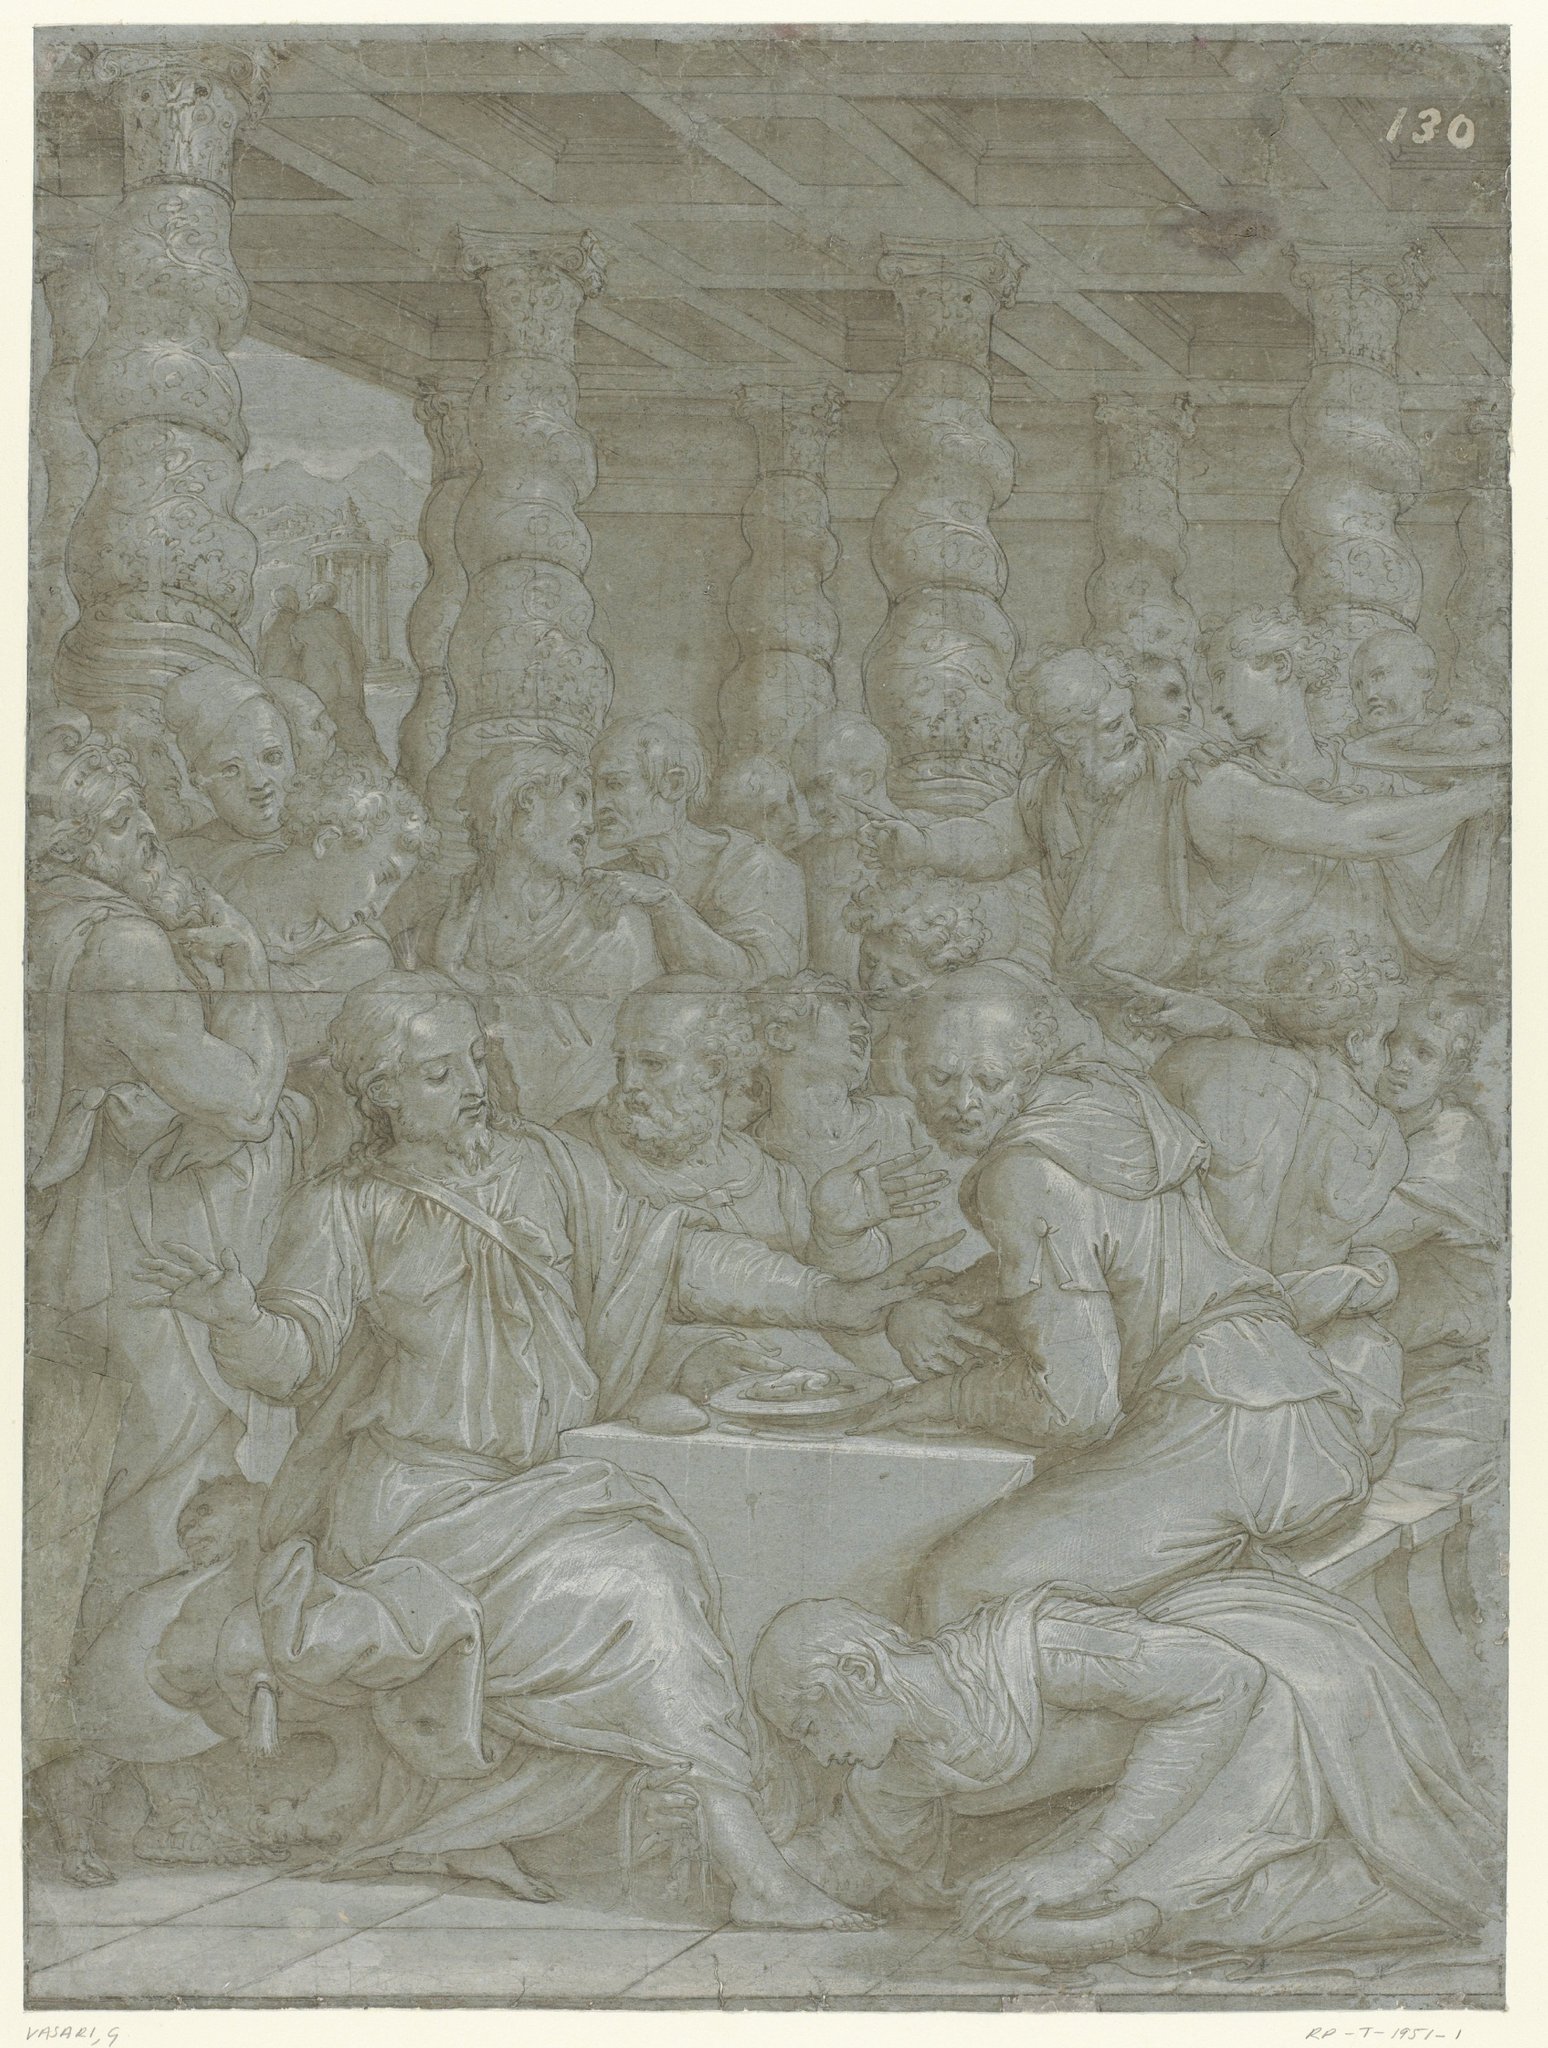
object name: drawing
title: Christ in the House of Simon the Pharisee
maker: giorgio vasari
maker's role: draughtsman, painter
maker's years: 1511-1574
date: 1544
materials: chalk, ink, paper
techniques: brush, pen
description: This detailed drawing on blue paper is a study for a mural in a refectory, the dining room of a monastery. Many of its figures are derived from Vasari’s own compositions or those of his contemporaries. They entirely fill the small loggia with its fantastical twisted columns. This horror-vacui, or fear of empty space, was a typical feature of Mannerism, the art movement to which Vasari belonged.